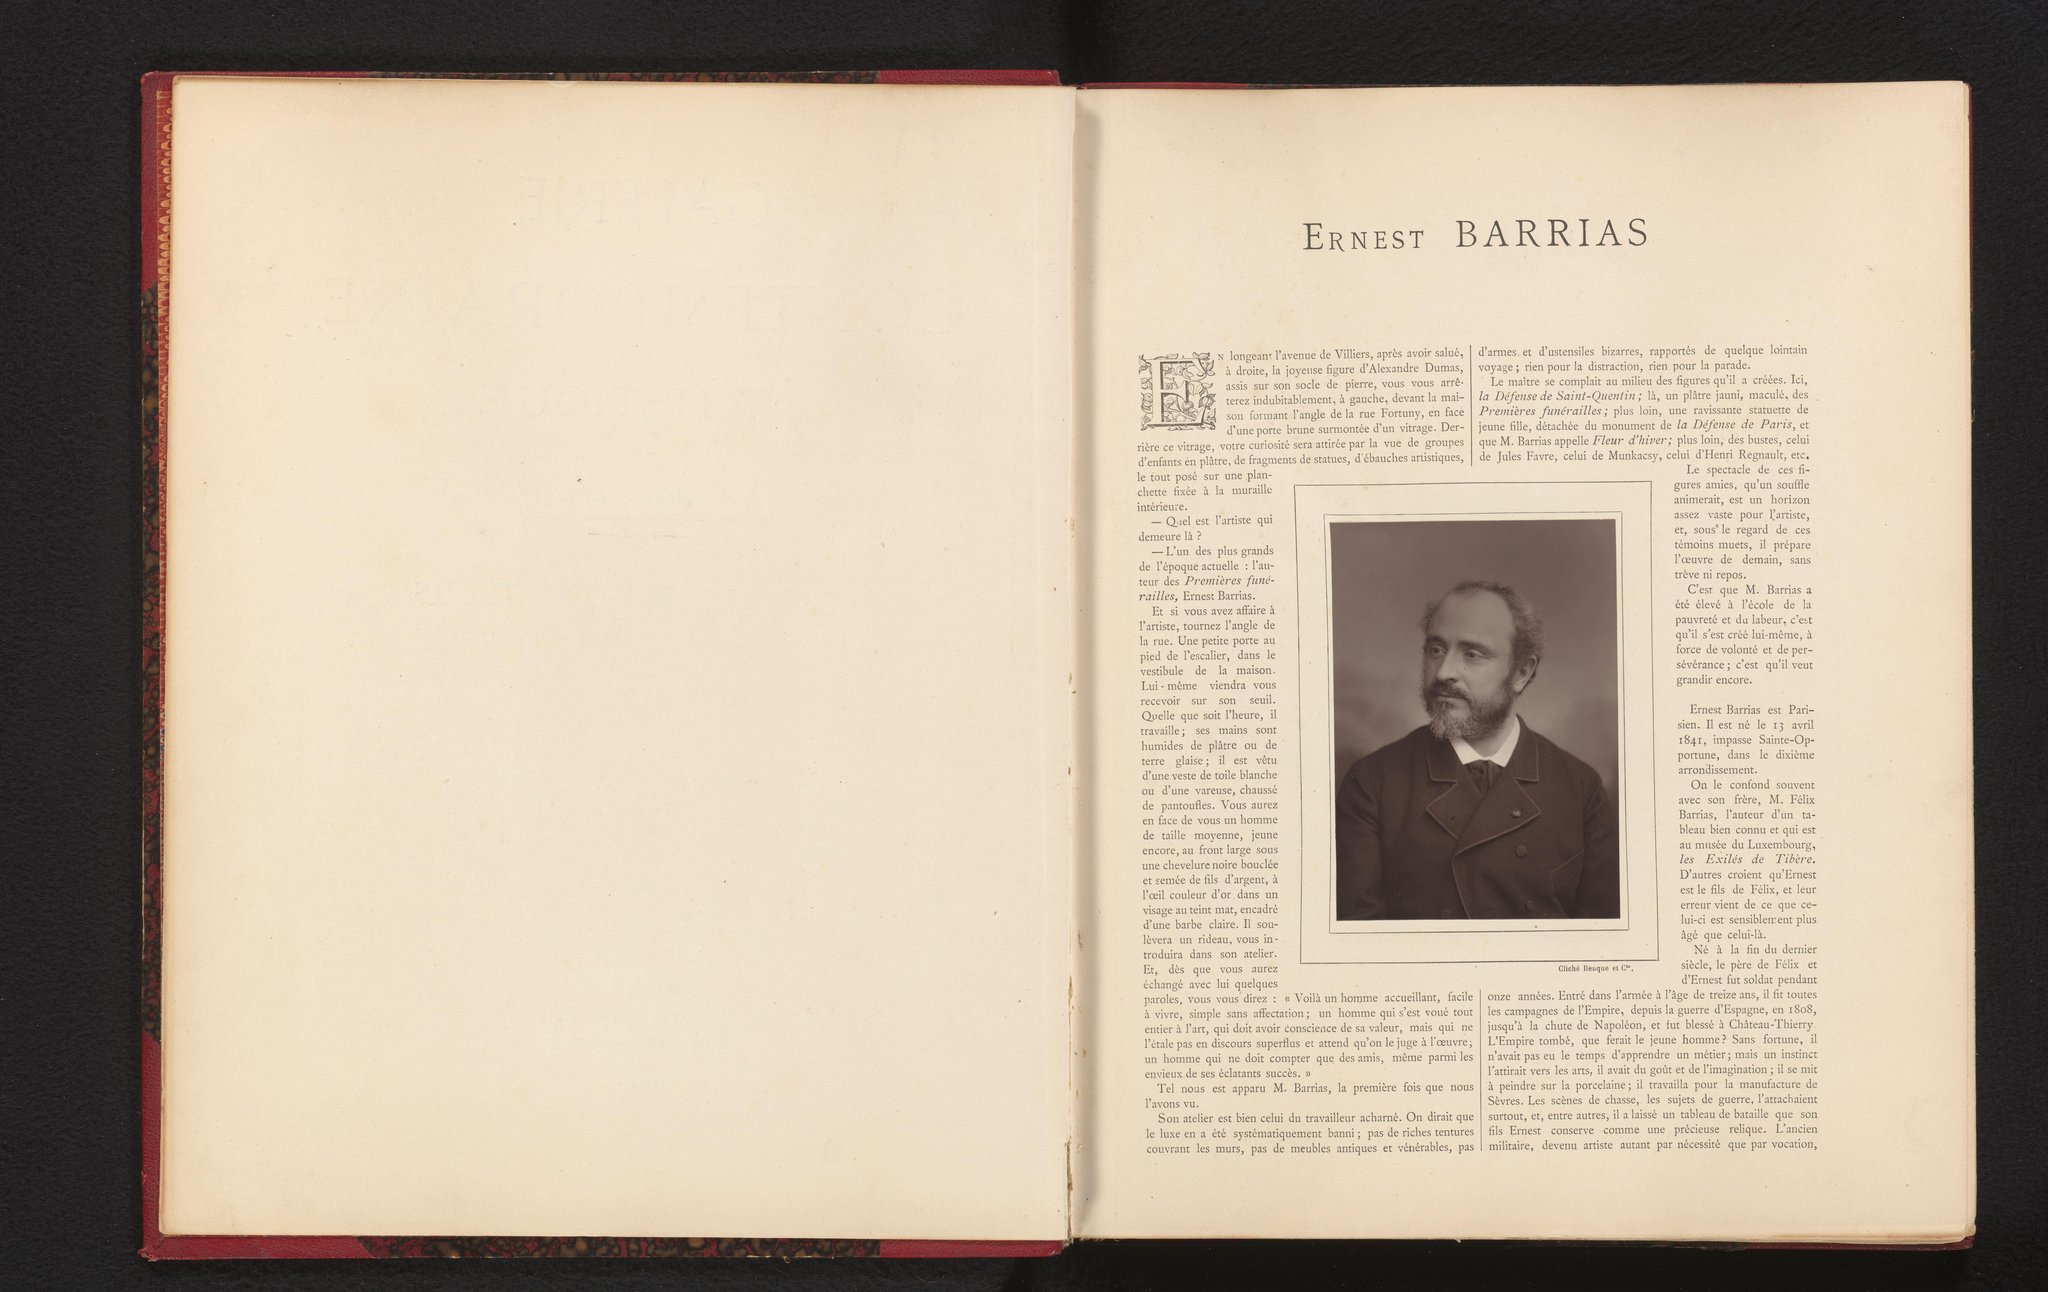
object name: photomechanical print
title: Portret van Louis-Ernest Barrias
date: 1879-1884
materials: paper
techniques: woodburytype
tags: paris, sculptor, louis-ernest barrias, historical persons